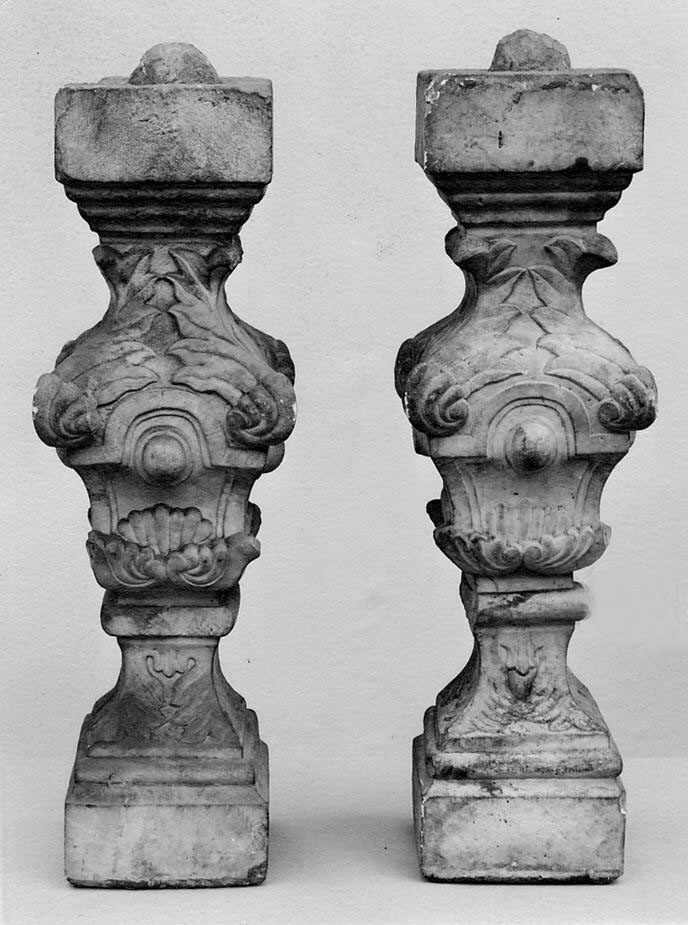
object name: baluster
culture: chinese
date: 1601-1800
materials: marble